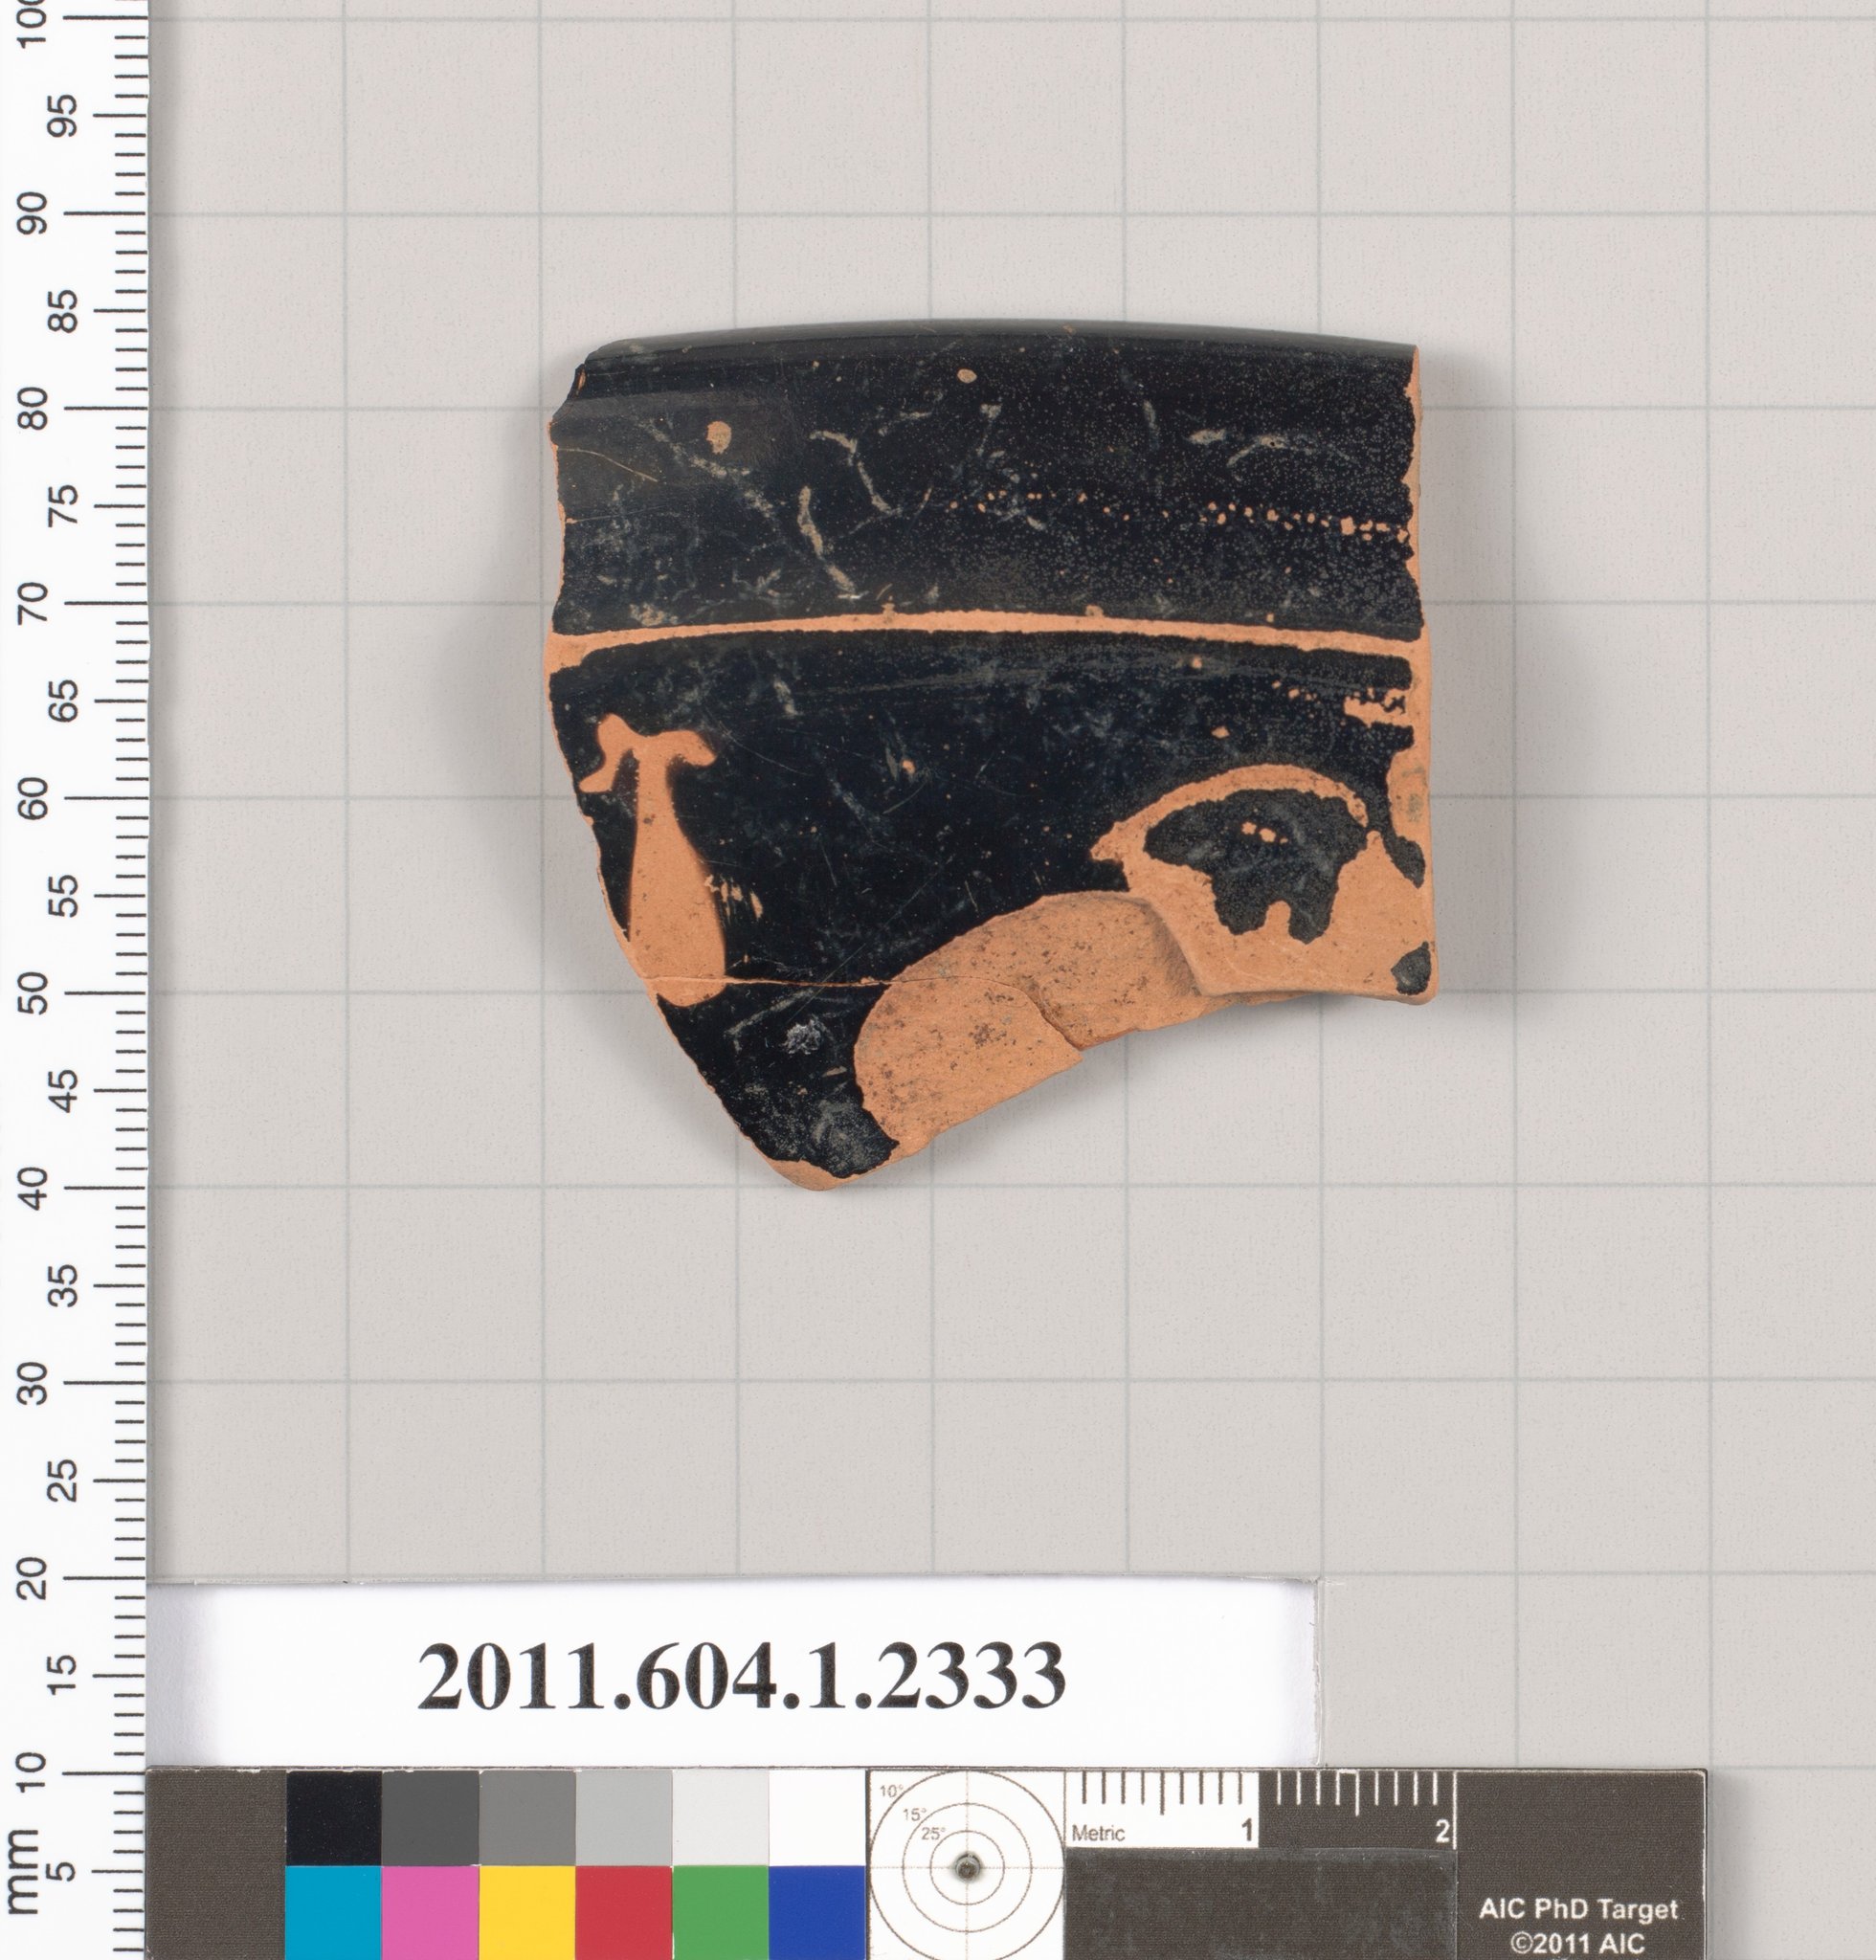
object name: kylix fragment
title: Terracotta rim fragment of a kylix (drinking cup)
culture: greek, attic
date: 467-435 BCE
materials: terracotta